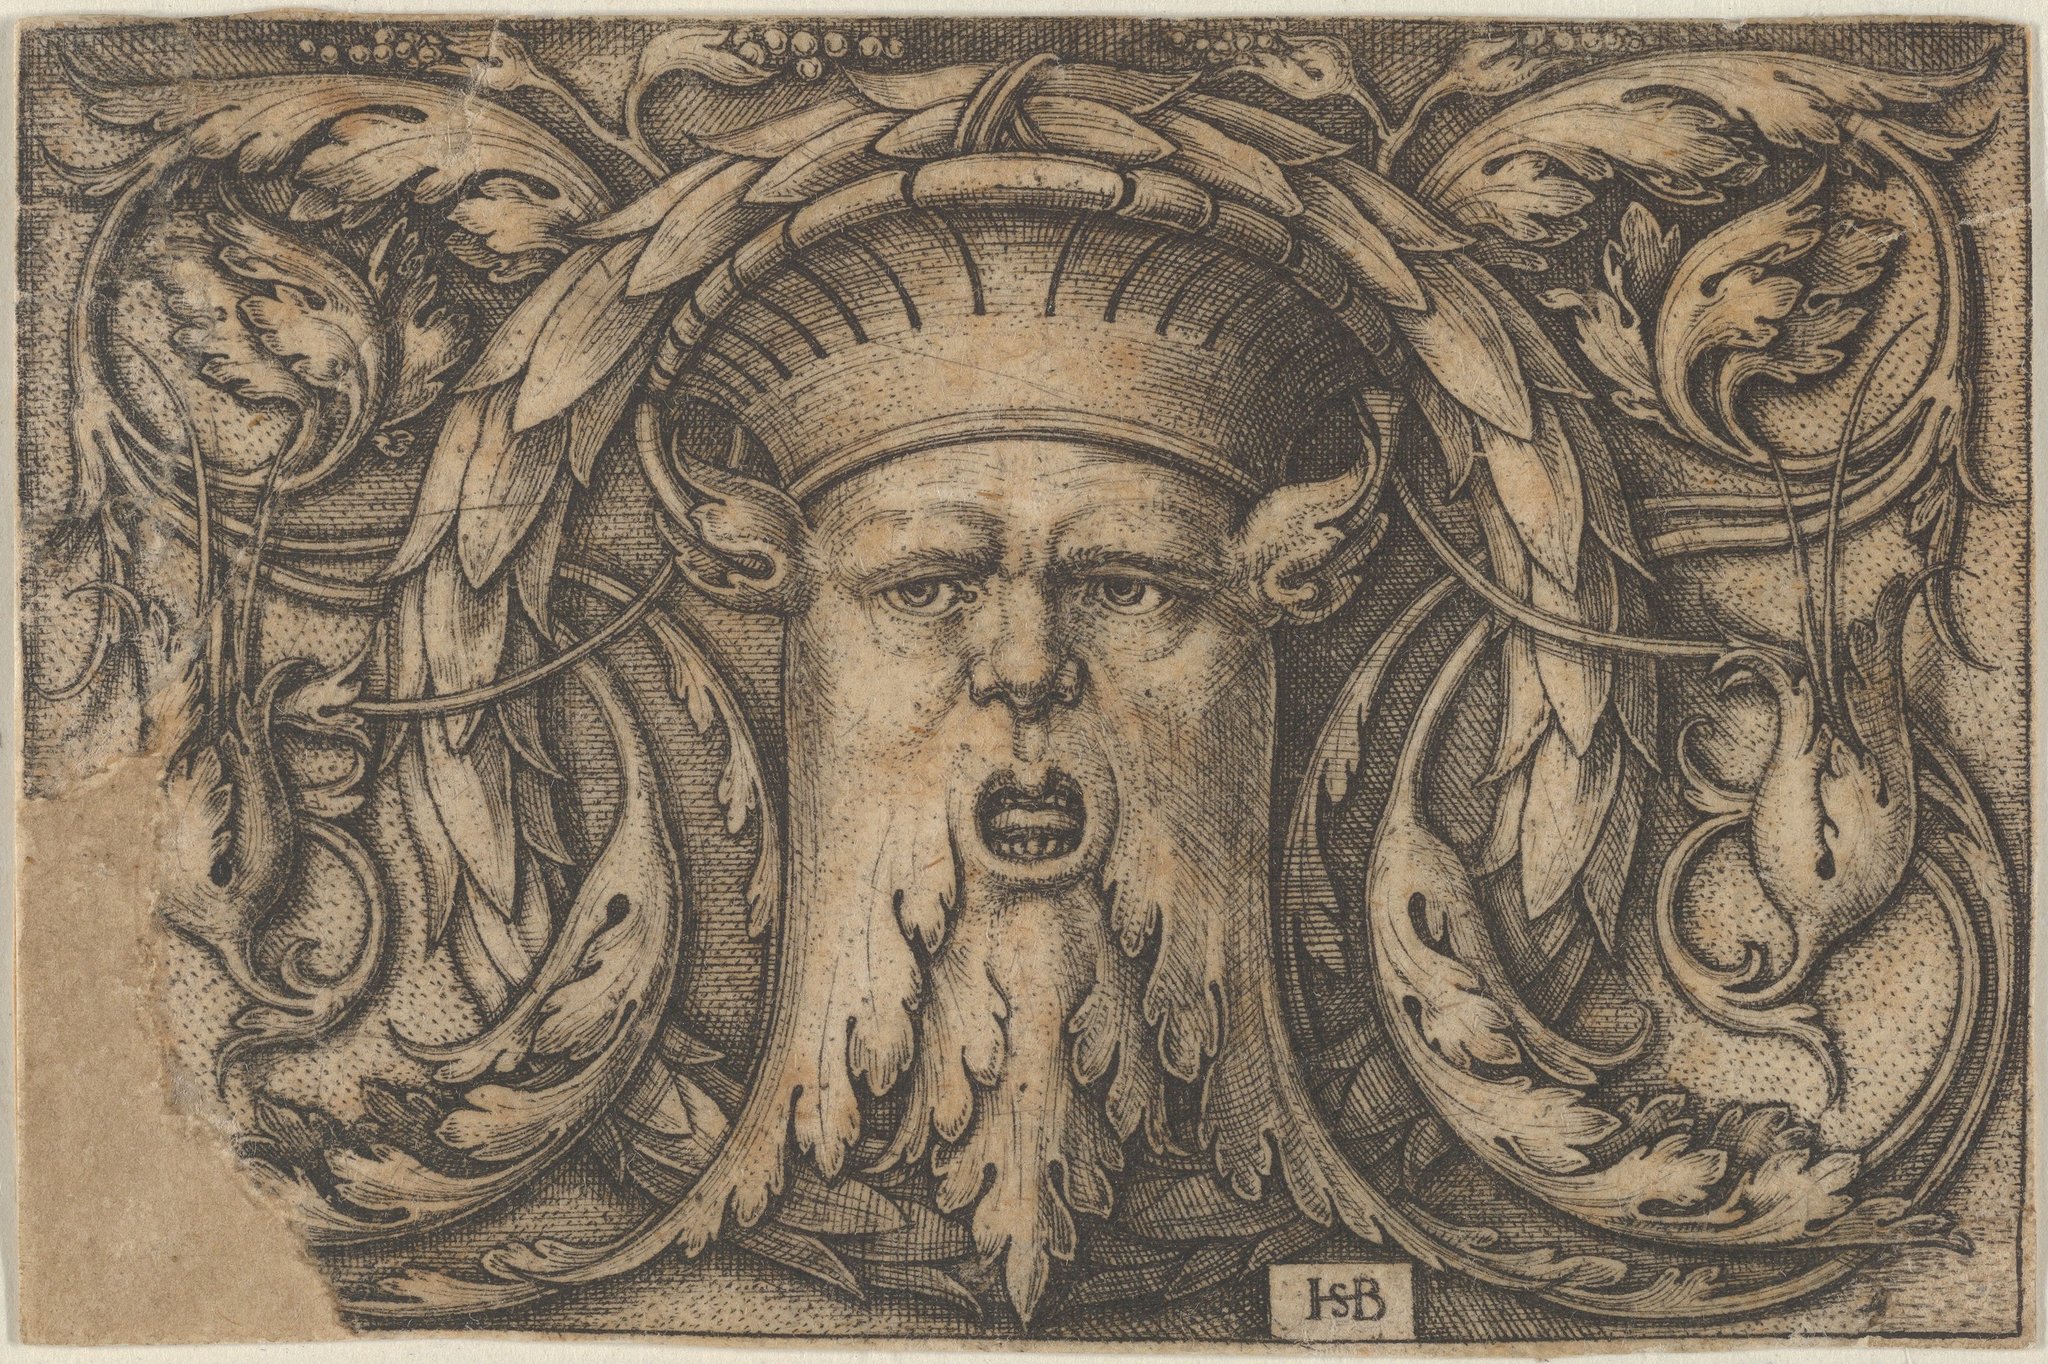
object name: print ornament architecture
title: Horizontal Panel with a Bearded Amascaron in a Medallion at Center Surrounded by Tendrils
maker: sebald beham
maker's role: artist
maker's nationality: german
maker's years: 1500-1550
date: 1543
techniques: engraving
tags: ornament